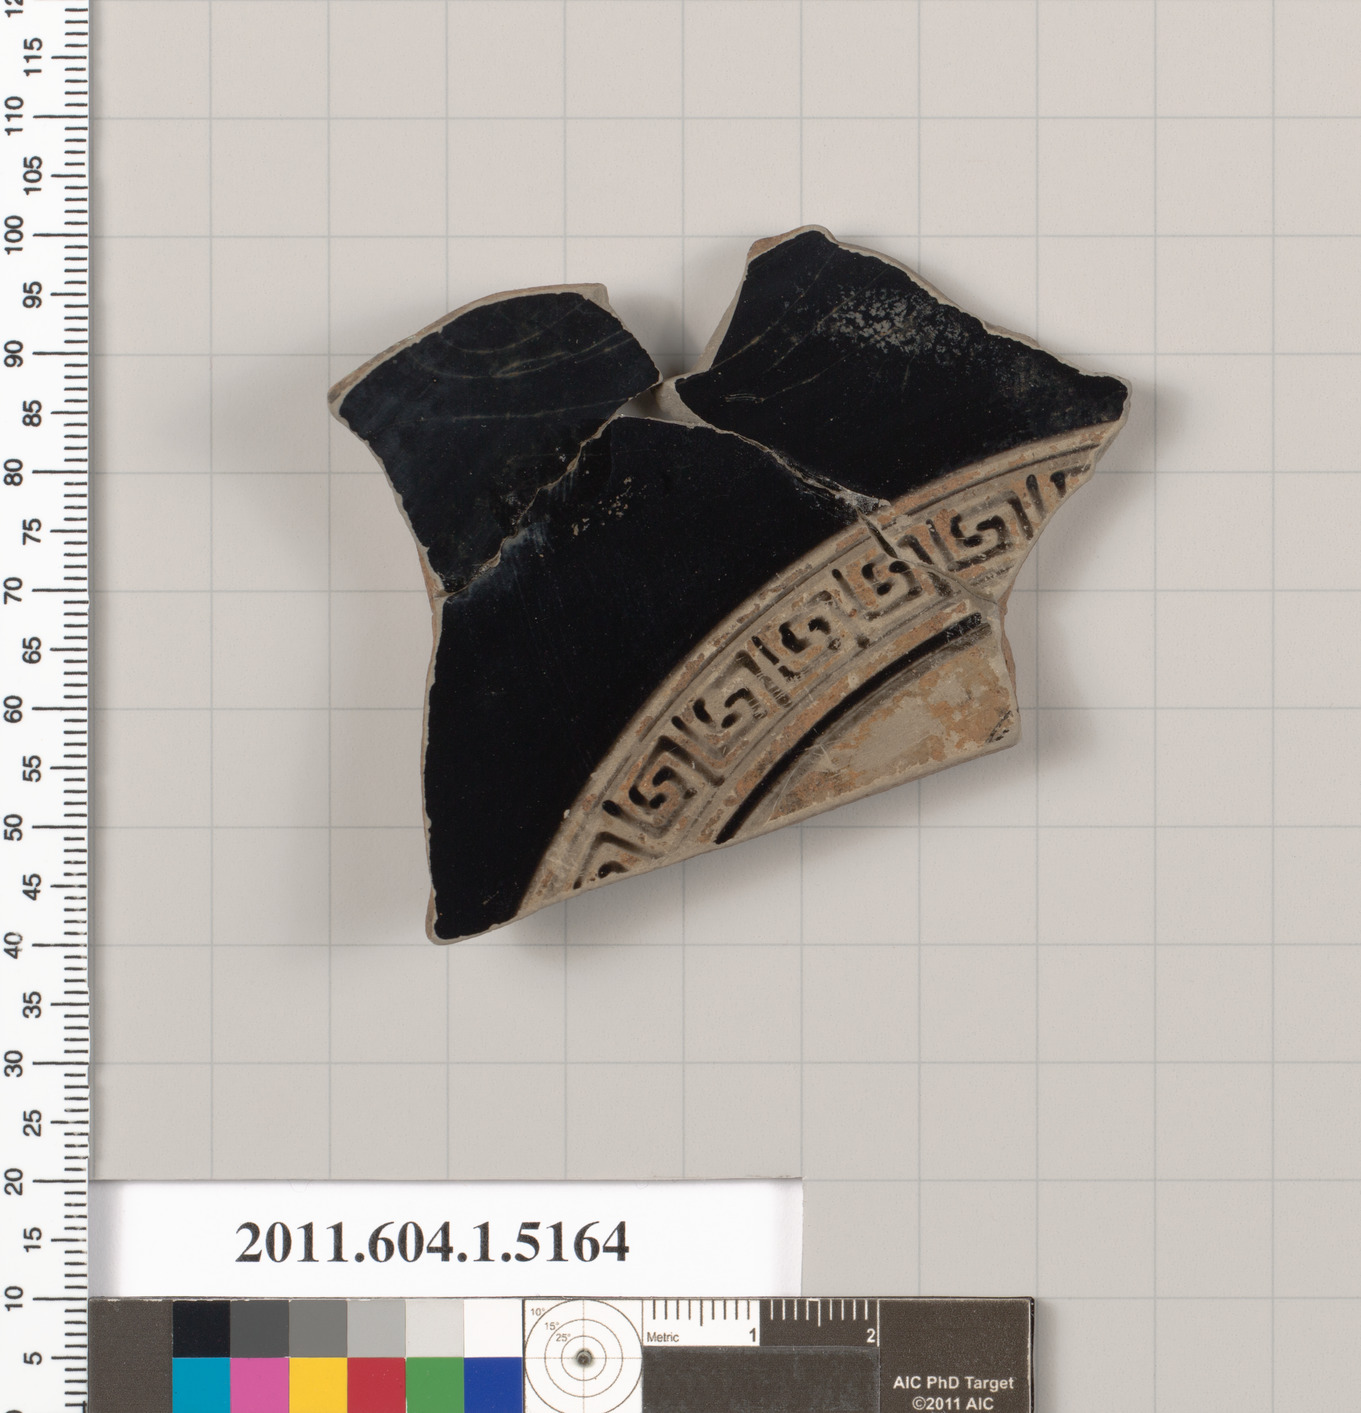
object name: kylix fragment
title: Terracotta fragment of a kylix (drinking cup)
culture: greek, attic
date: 500-480 BCE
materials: terracotta